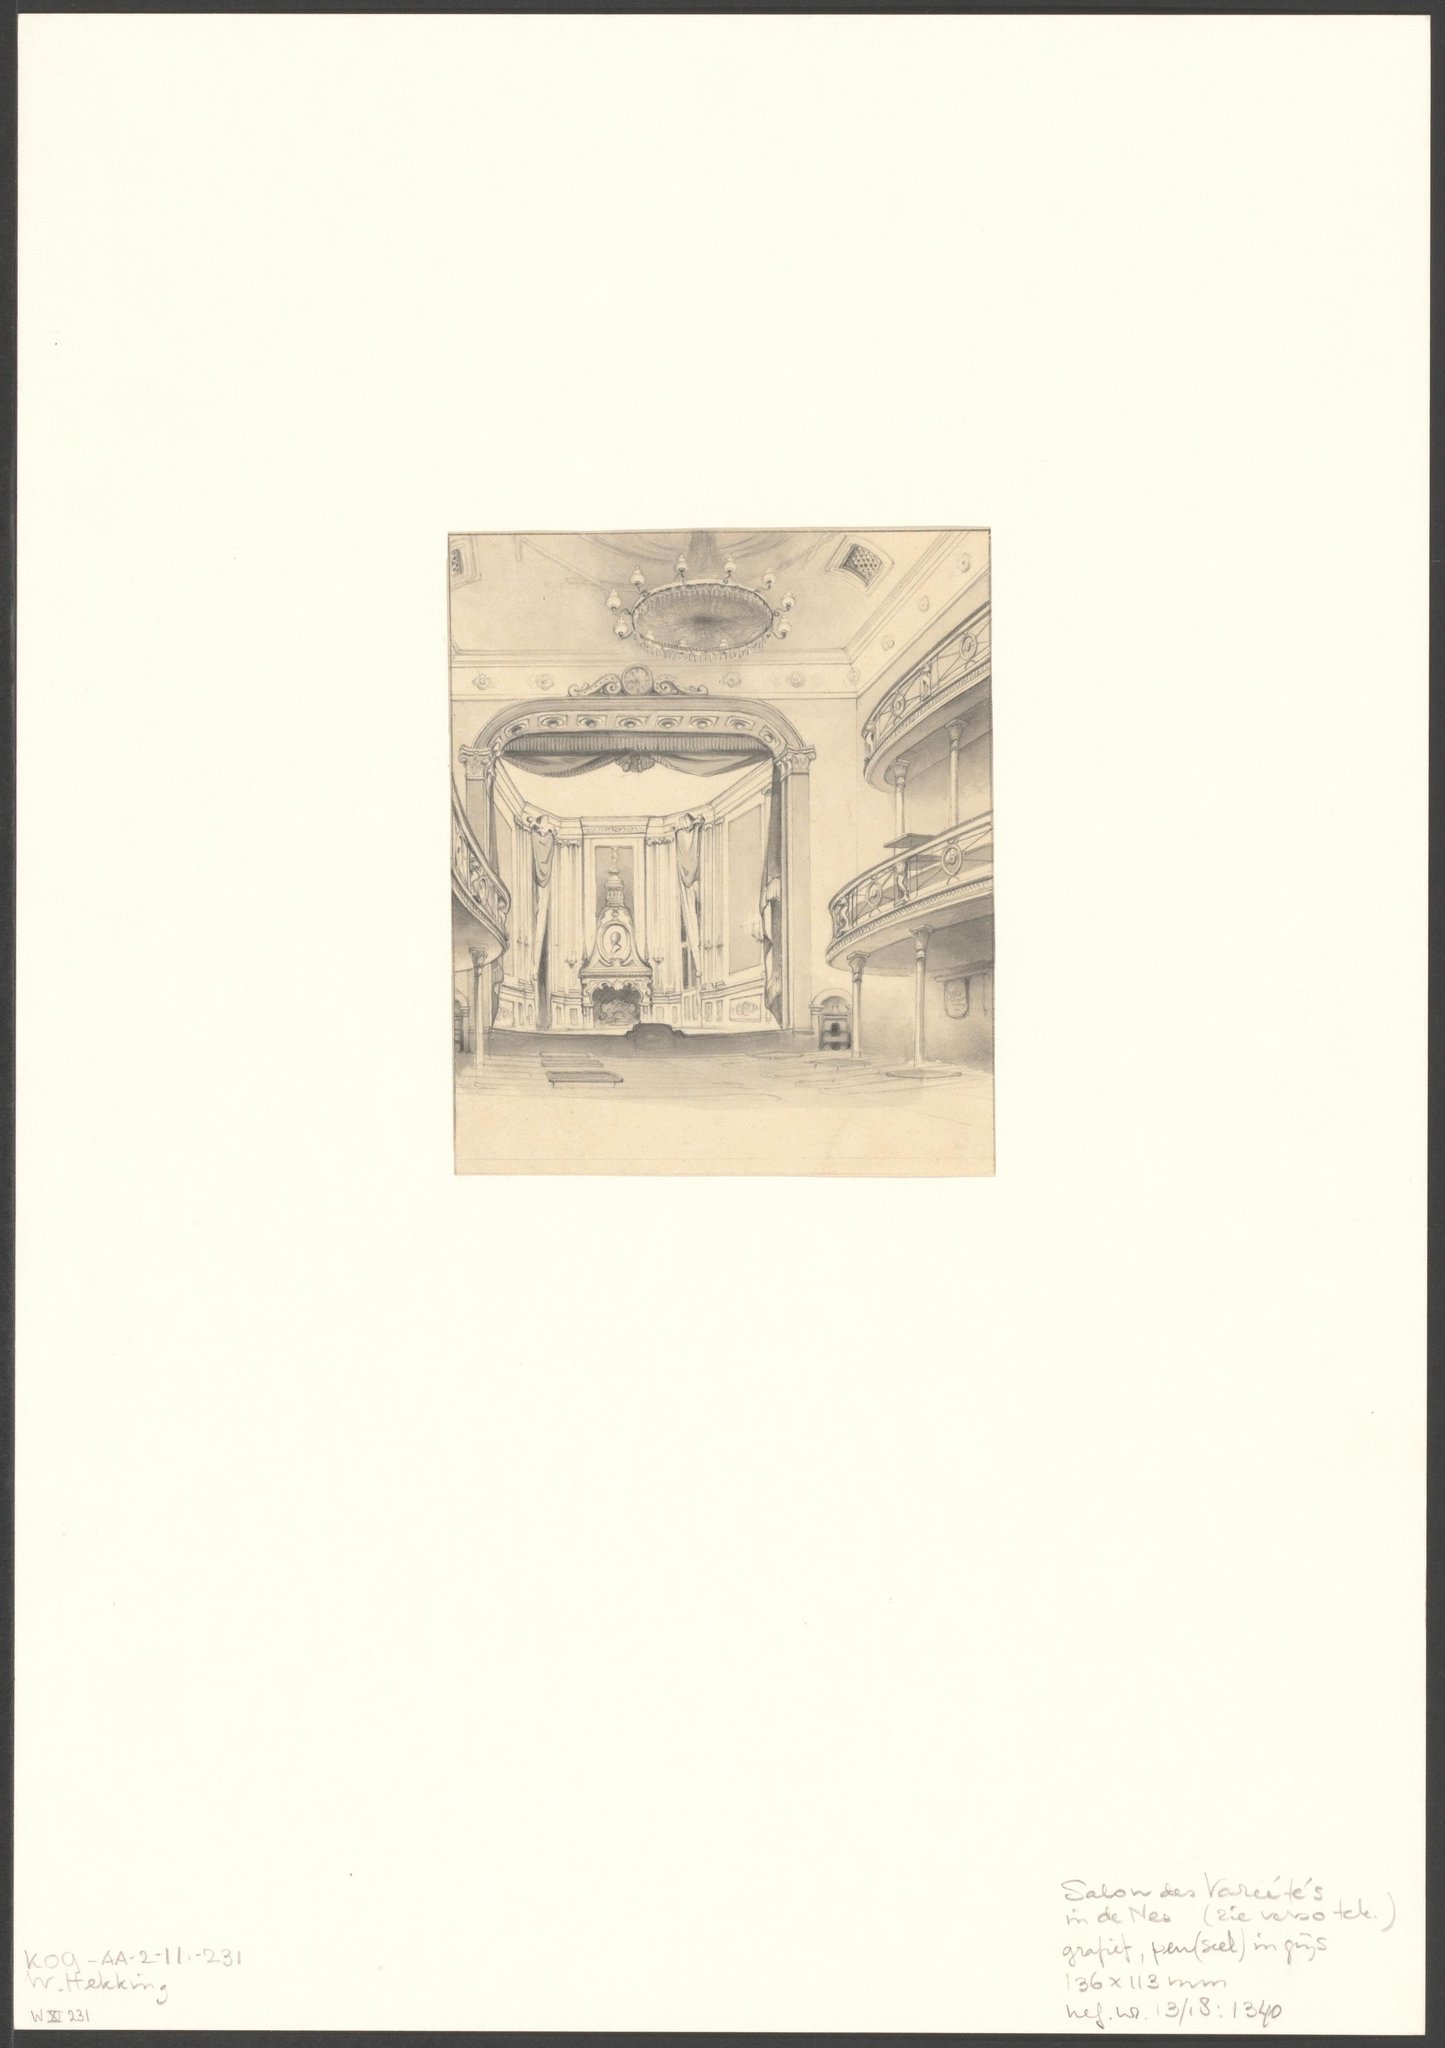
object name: drawing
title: Interieur van de Salon des Variétés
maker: Anonymous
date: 1863-1899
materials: ink, paper, pencil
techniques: brush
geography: amsterdam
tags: theatre, theatrical performance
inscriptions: inscription: ‘De Salon des Variétés In de Nes. / van den Heer Duport. / Geopend 2 Sep (?) 1839. / Afgebroken omstr 1863.’, collector's mark: Lugt 800a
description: Tekening binnen de Atlas Van Eck ingedeeld op wijknummer 11.